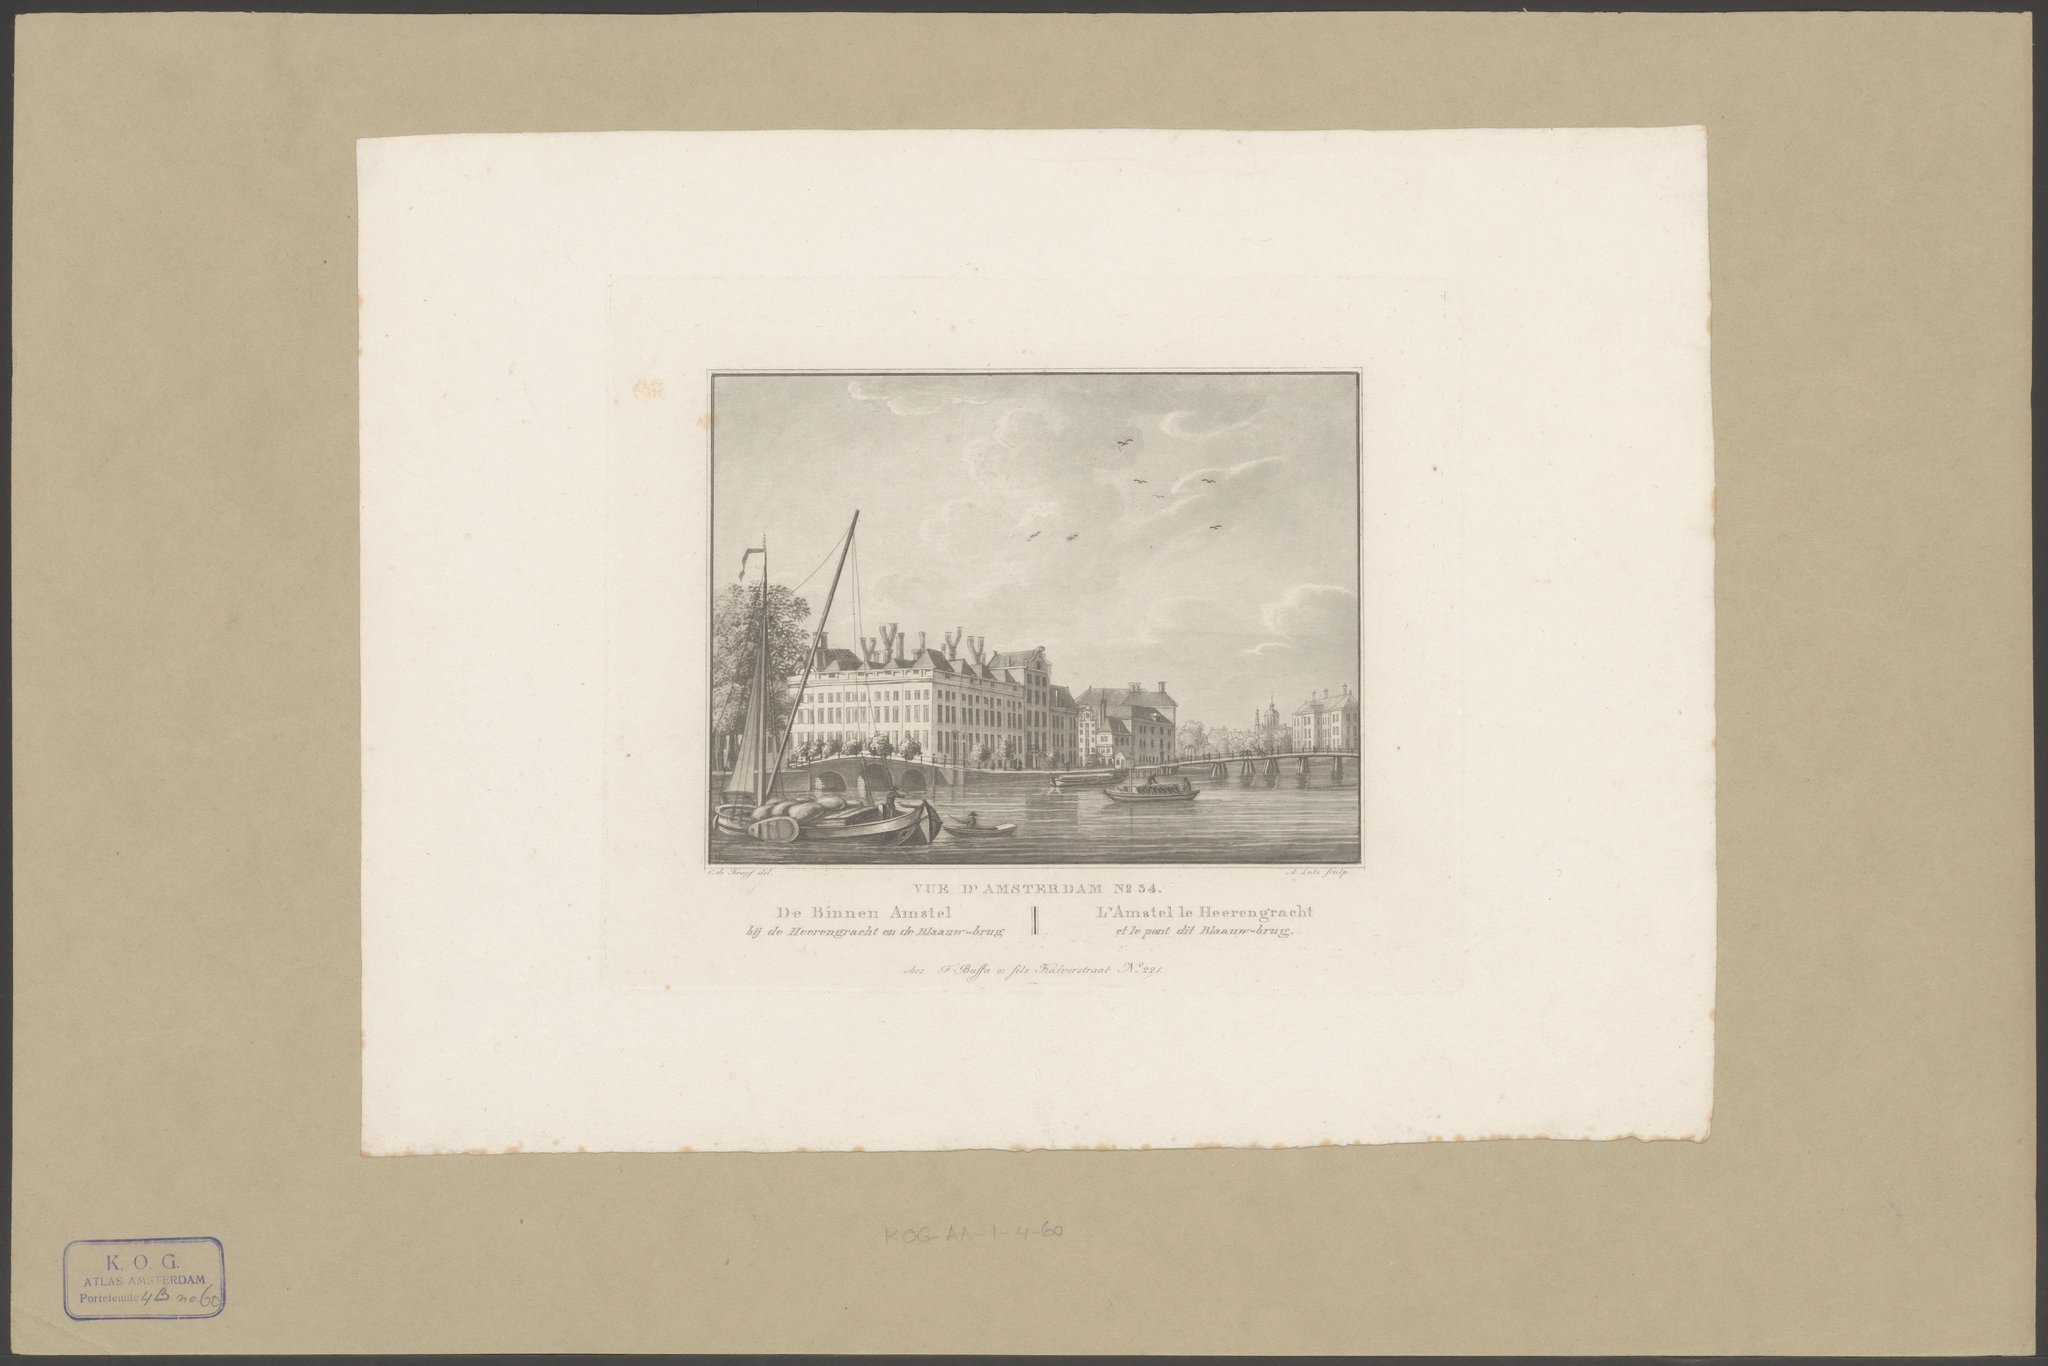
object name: print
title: Gezicht op de Binnen-Amstel bij de Blauwbrug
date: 1825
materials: paper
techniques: aquatint, etching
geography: amsterdam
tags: city-view in general; 'veduta', canal, ships (in general) - cc - more than one ship, bridge in city across river, canal, etc., boat propelled by man or animal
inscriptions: collector's mark: ‘4B no60’ Lugt 1641b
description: Onderwerpsrubriek binnen de Atlas Amsterdam: Amstel van Blauwbrug tot Hogesluis.